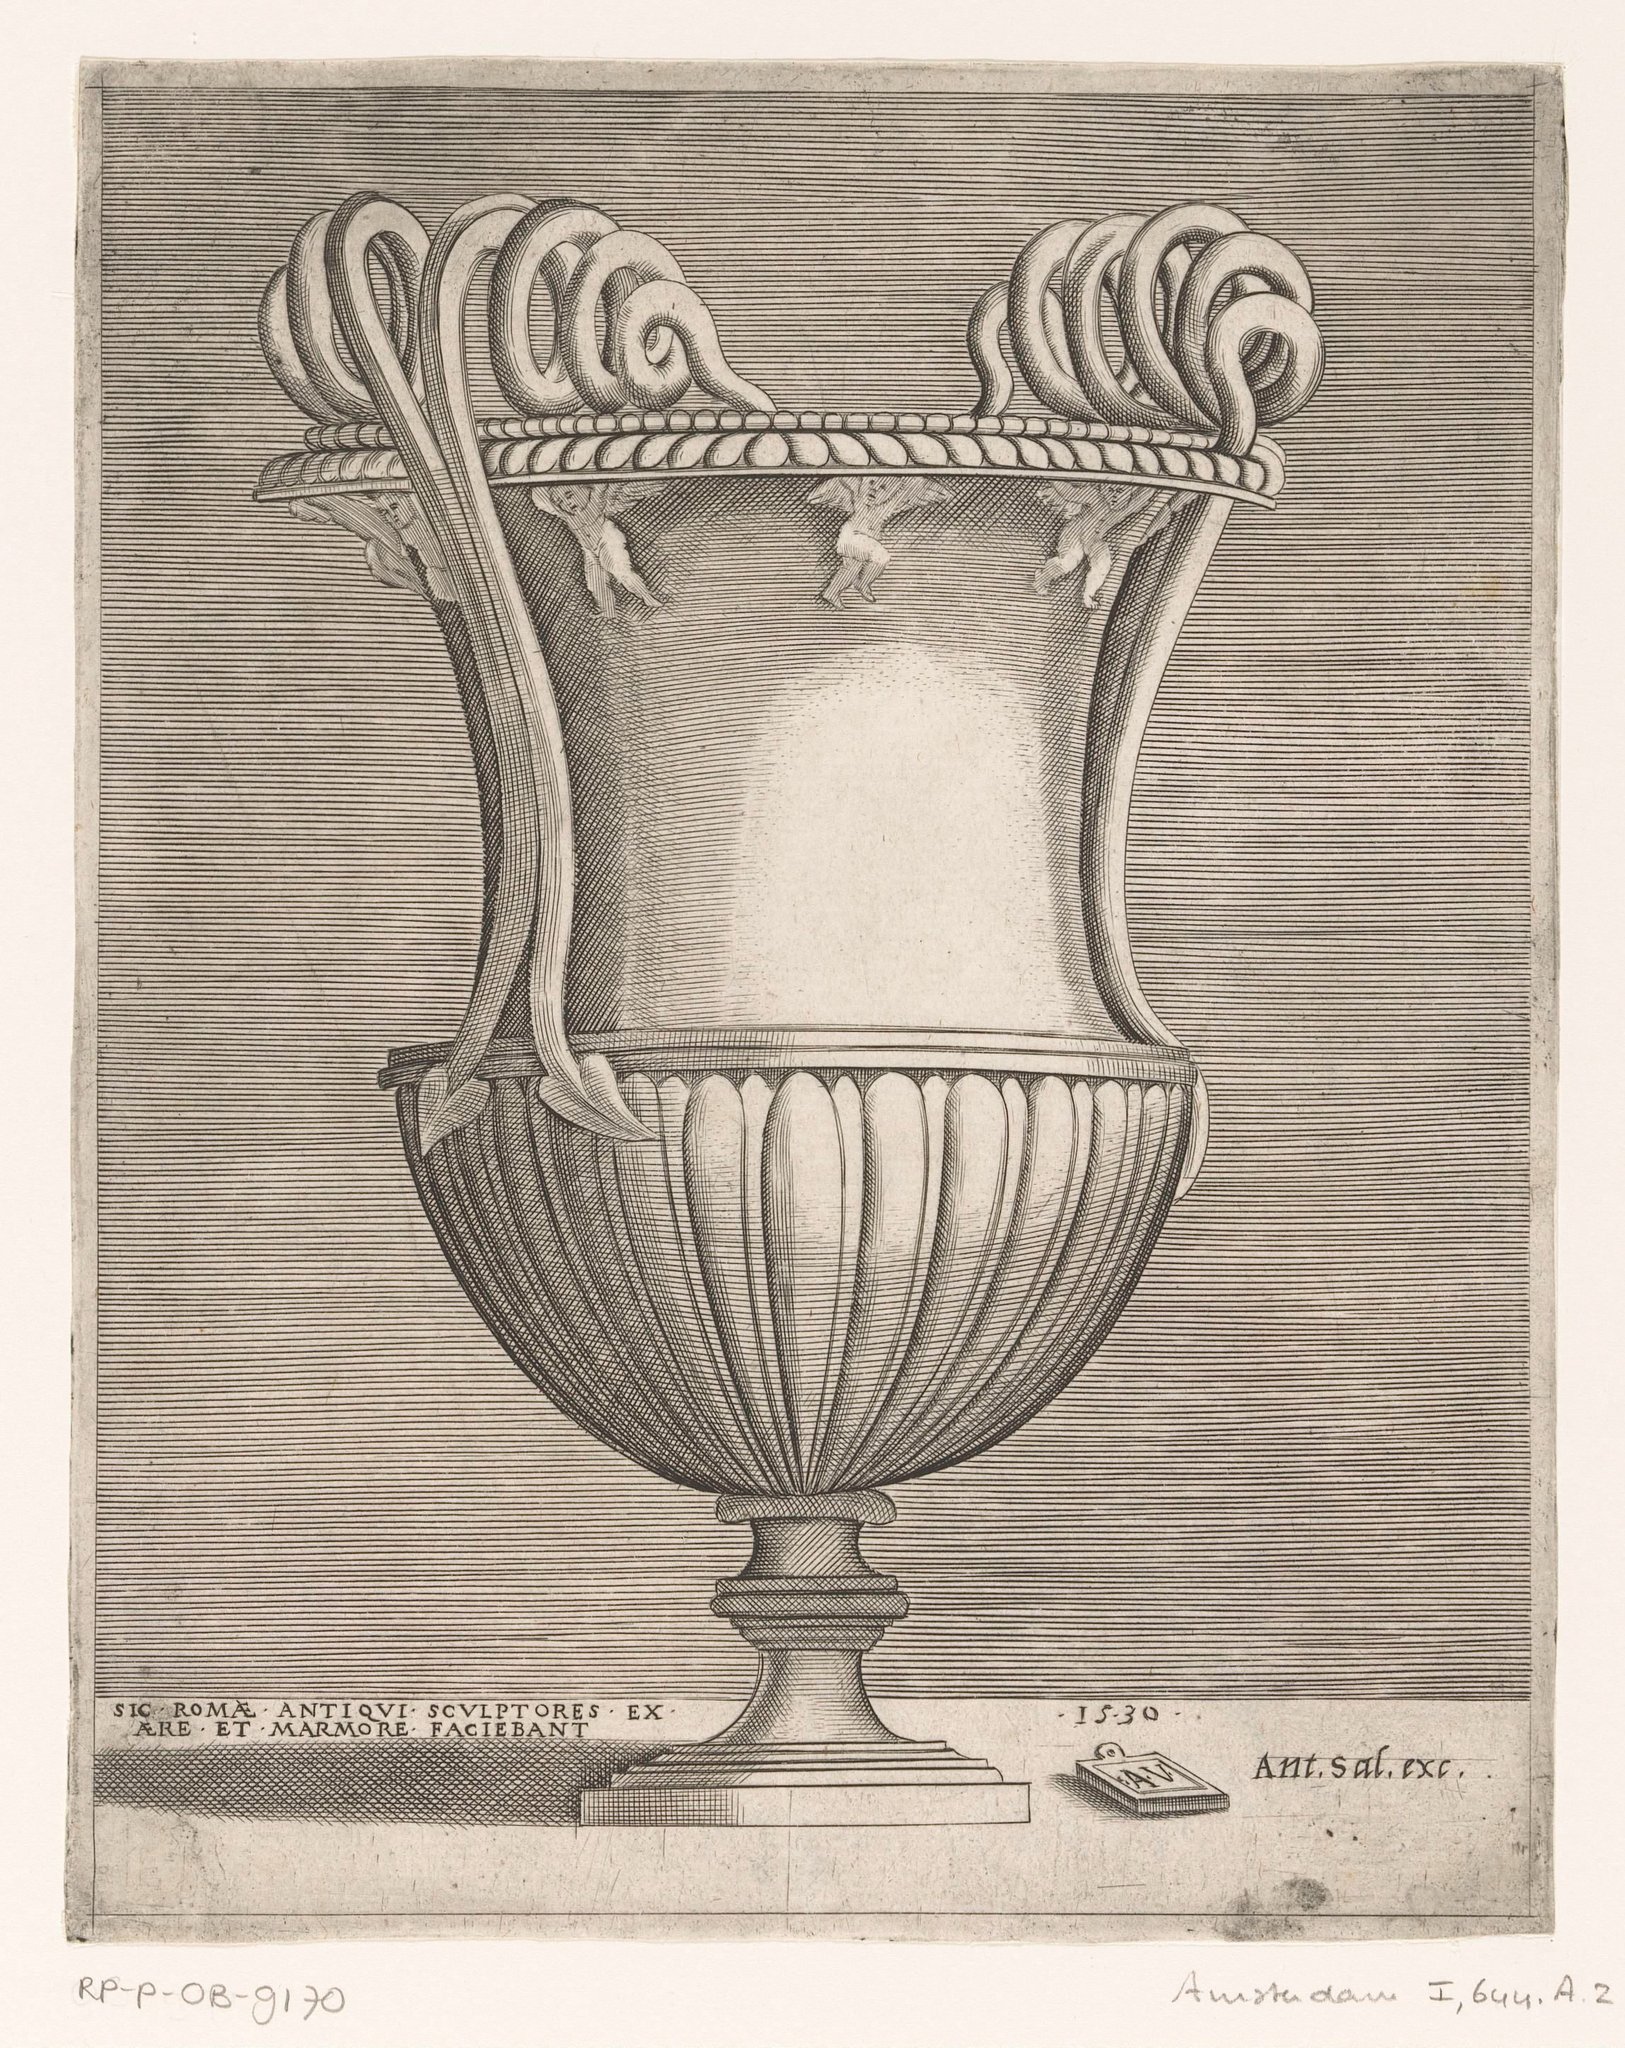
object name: print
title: Ornamentele vaas met twee handvatten en een rand van putti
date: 1530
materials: paper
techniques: engraving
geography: rome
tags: vase ~ ornament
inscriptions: collector's mark: Lugt 2228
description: Deze prent maakt deel uit van een reeks van dertien prenten van vazen.